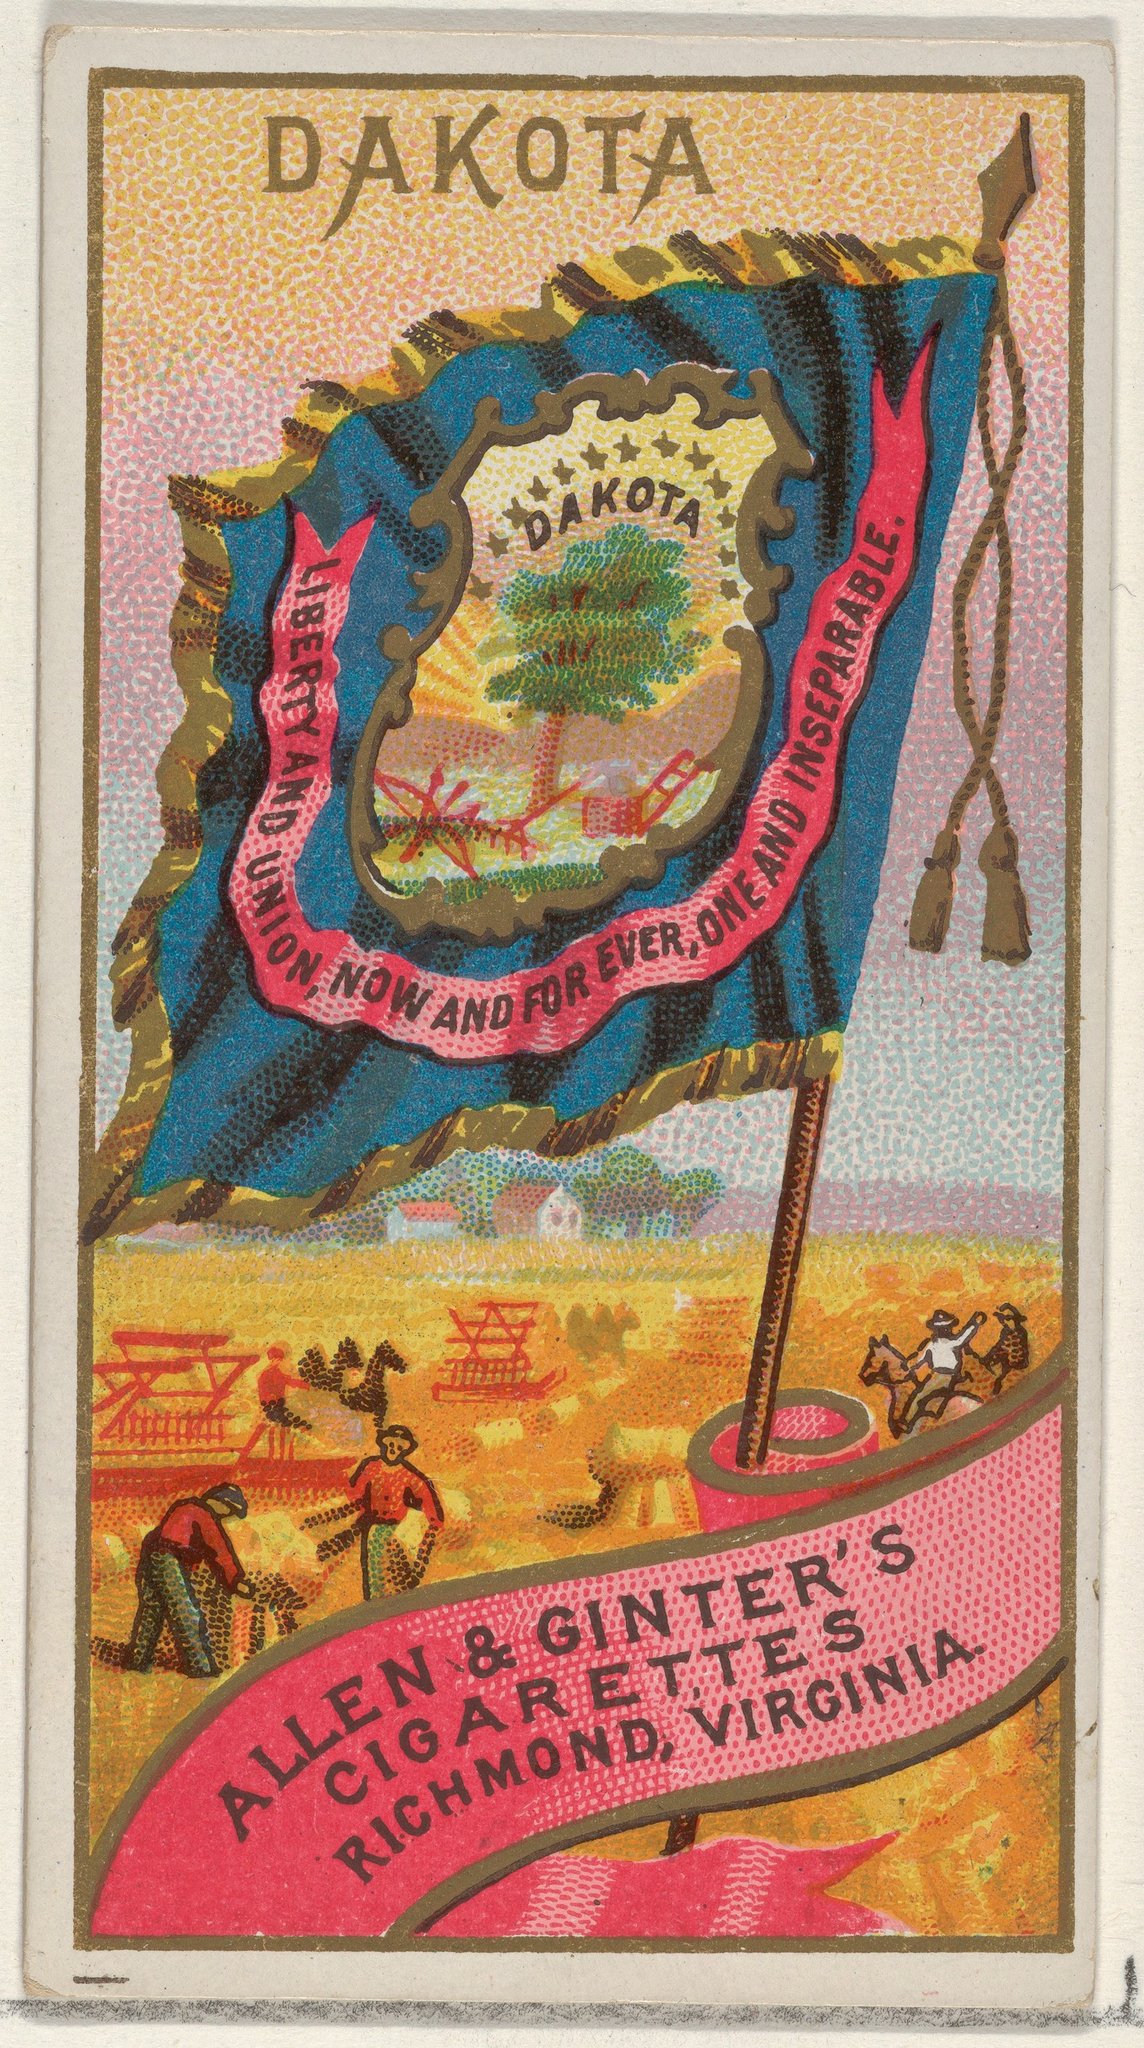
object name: print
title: Dakota, from Flags of the States and Territories (N11) for Allen & Ginter Cigarettes Brands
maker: allen & ginter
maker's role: publisher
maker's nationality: american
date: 1888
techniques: color lithograph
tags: flags